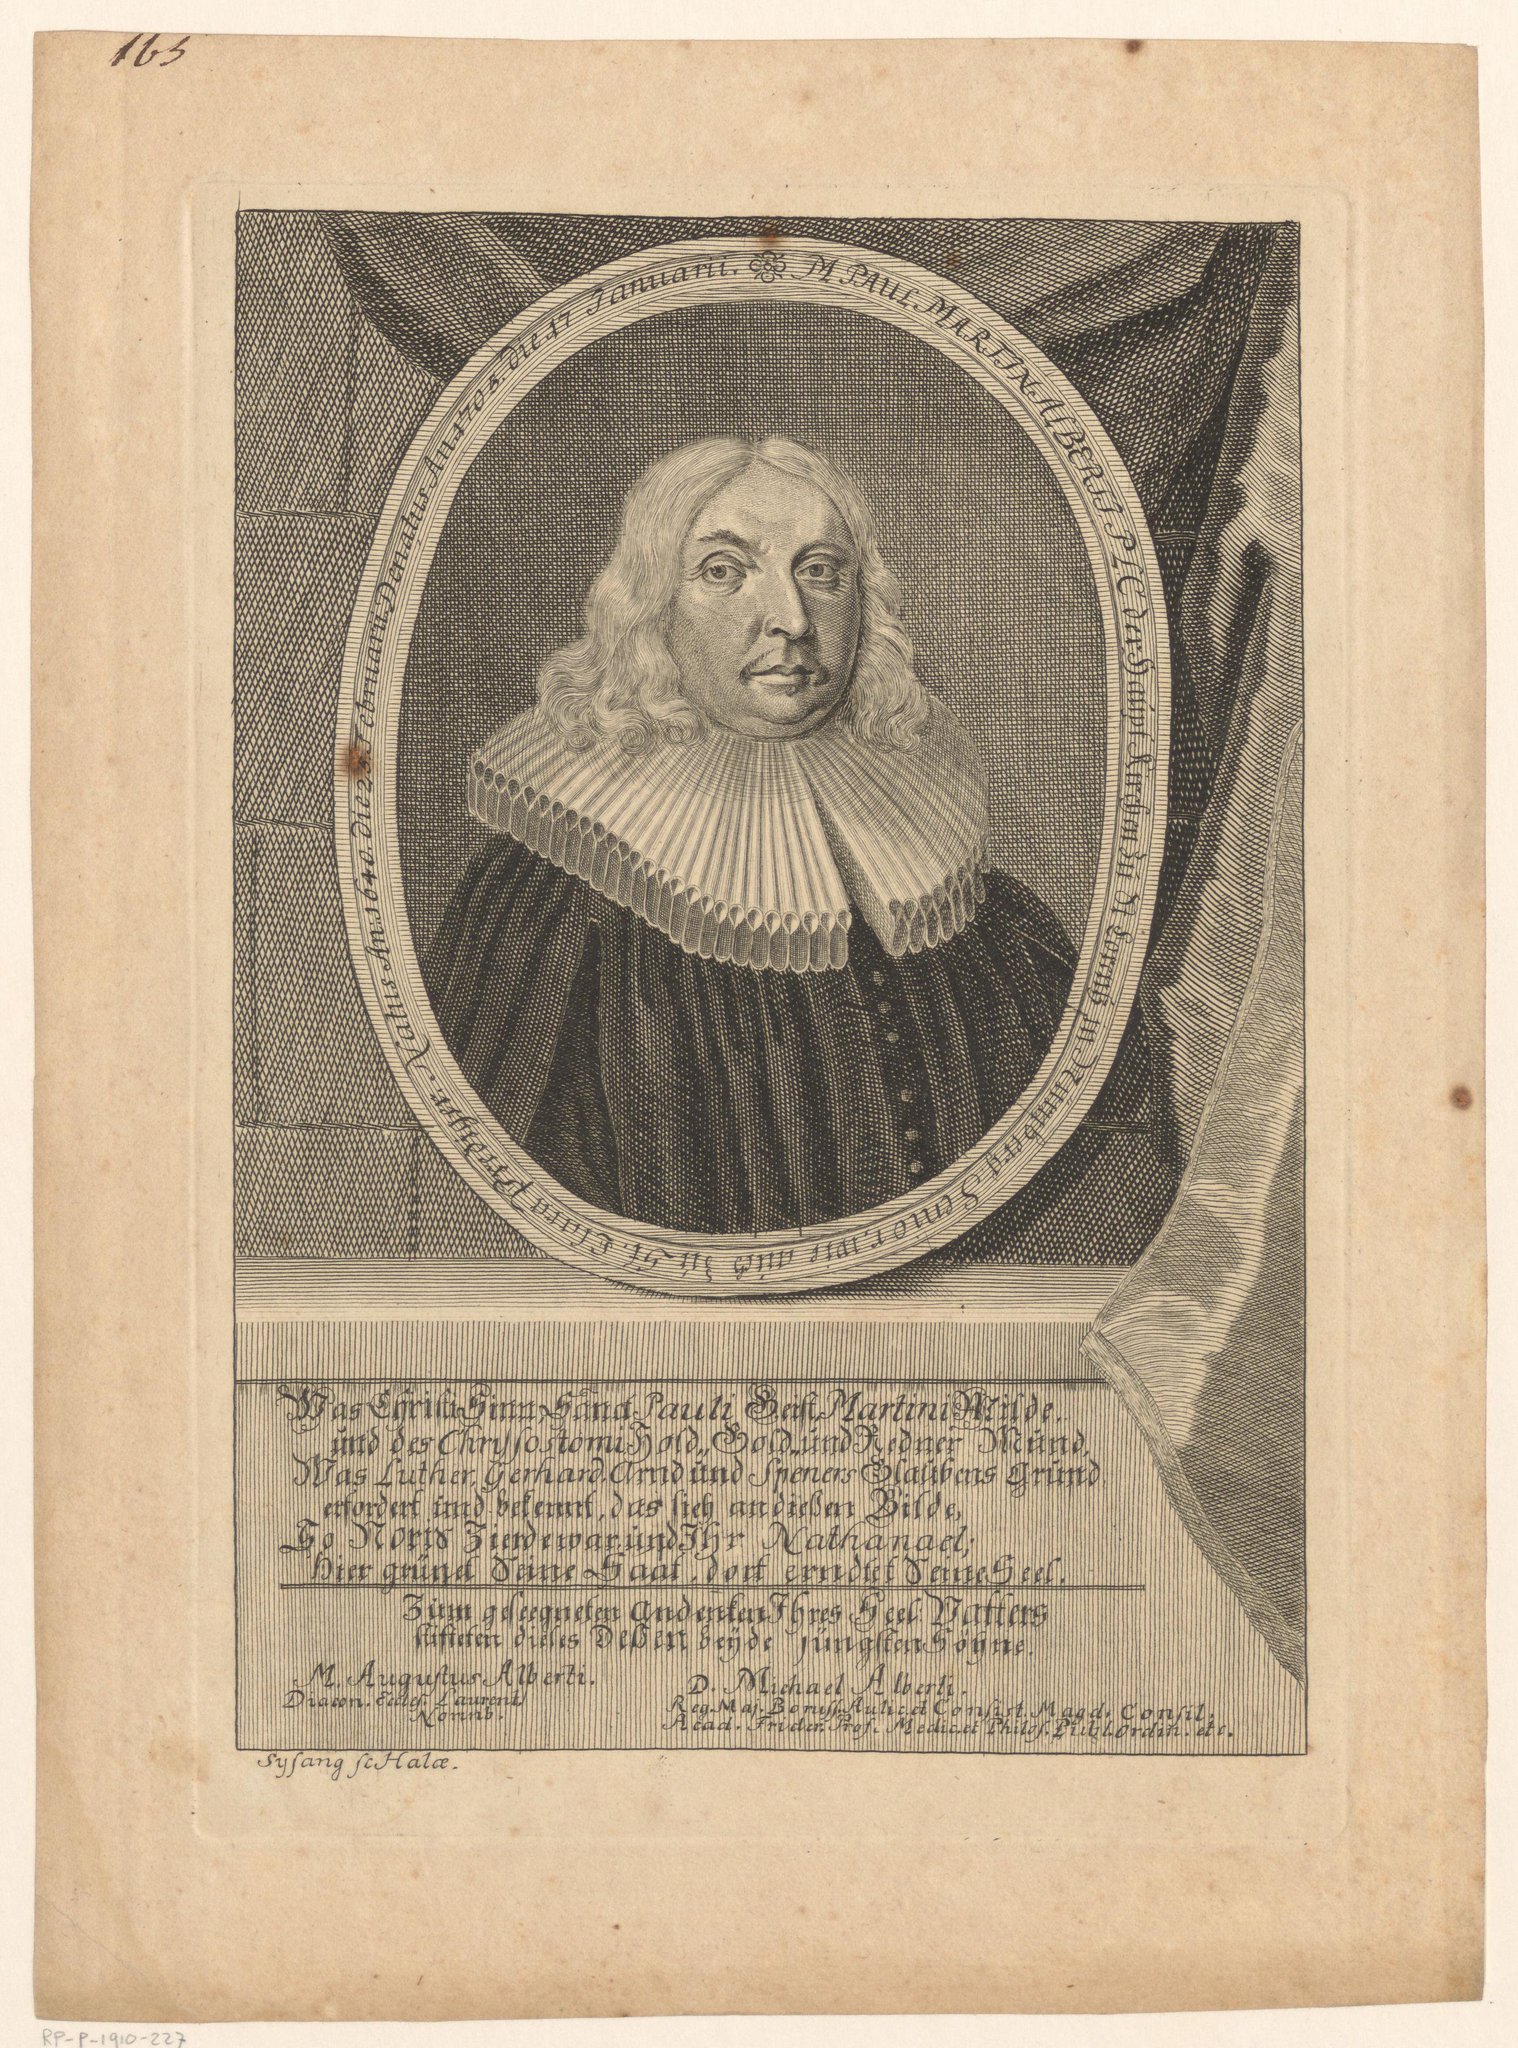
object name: print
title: Portret van Paul Martin Alberti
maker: johann christoph sysang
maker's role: print maker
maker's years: 1703-1757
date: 1713-1757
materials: paper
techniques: engraving, etching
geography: halle an der saale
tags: historical persons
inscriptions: collector's mark: Lugt 2228, number: ‘163’